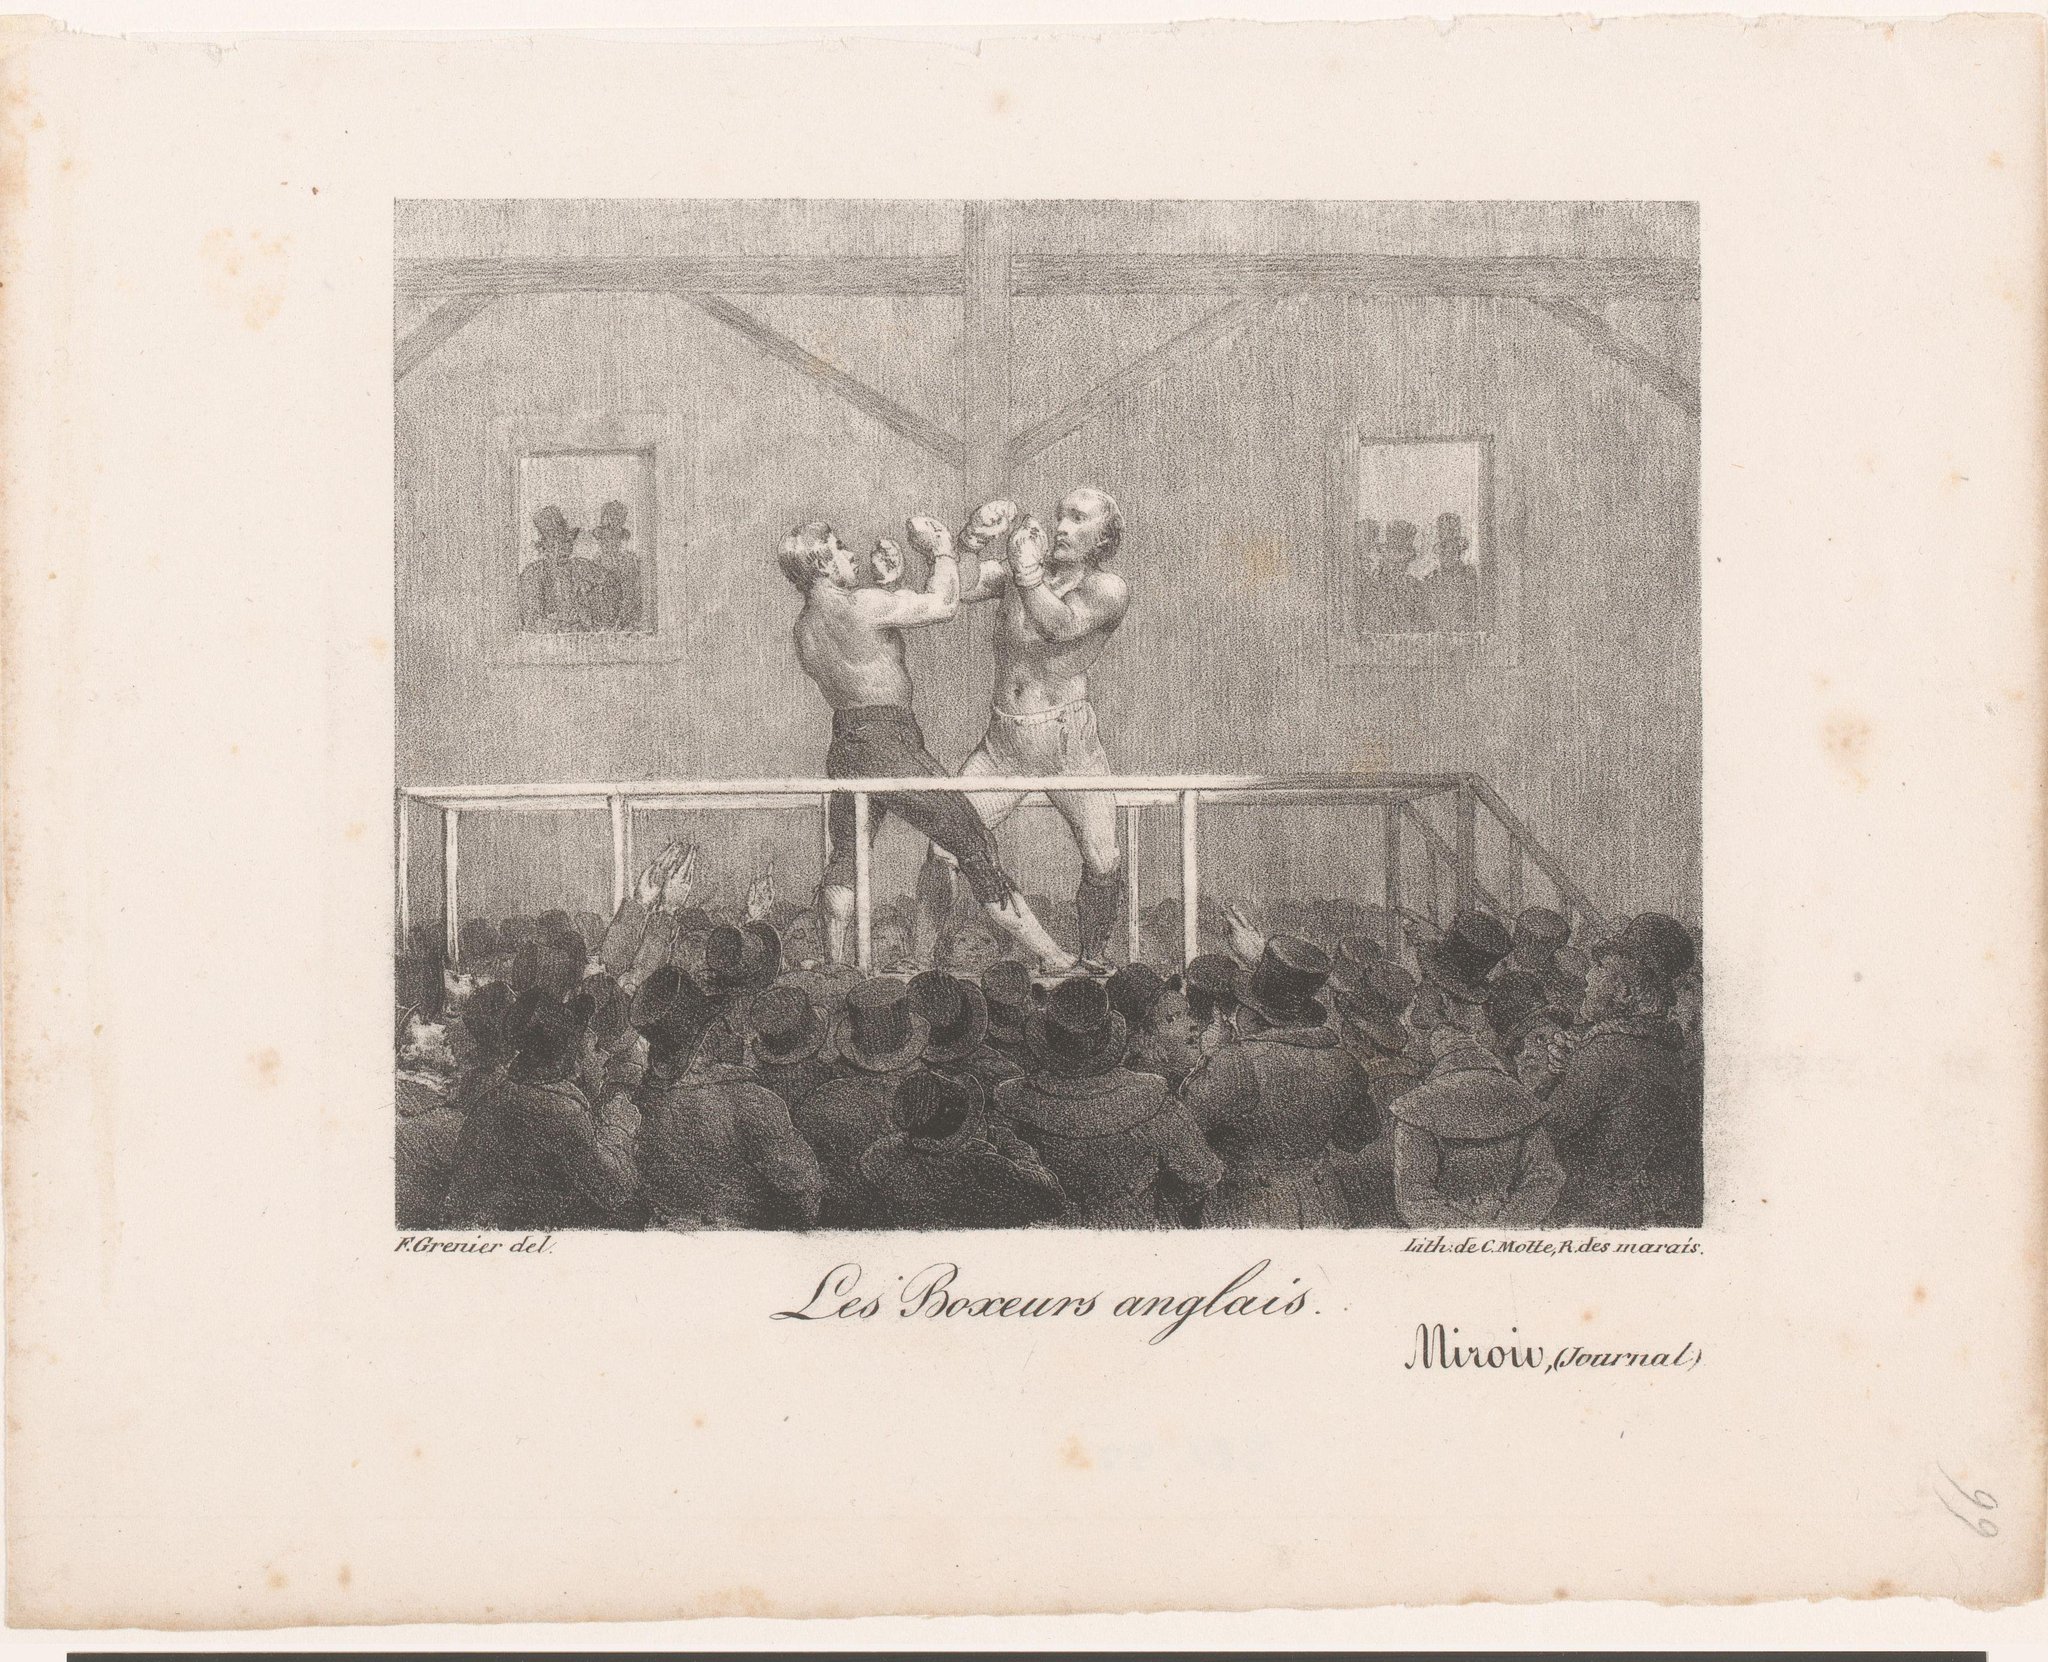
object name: print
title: Twee Engelse boksers te midden van het publiek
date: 1821-1823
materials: paper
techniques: lithograph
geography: paris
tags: boxing (sport)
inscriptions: collector's mark: Lugt 2228a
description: Prent gebruikt in: Le Miroir des spectacles, des lettres, des mœurs et des arts, 1821-1823.